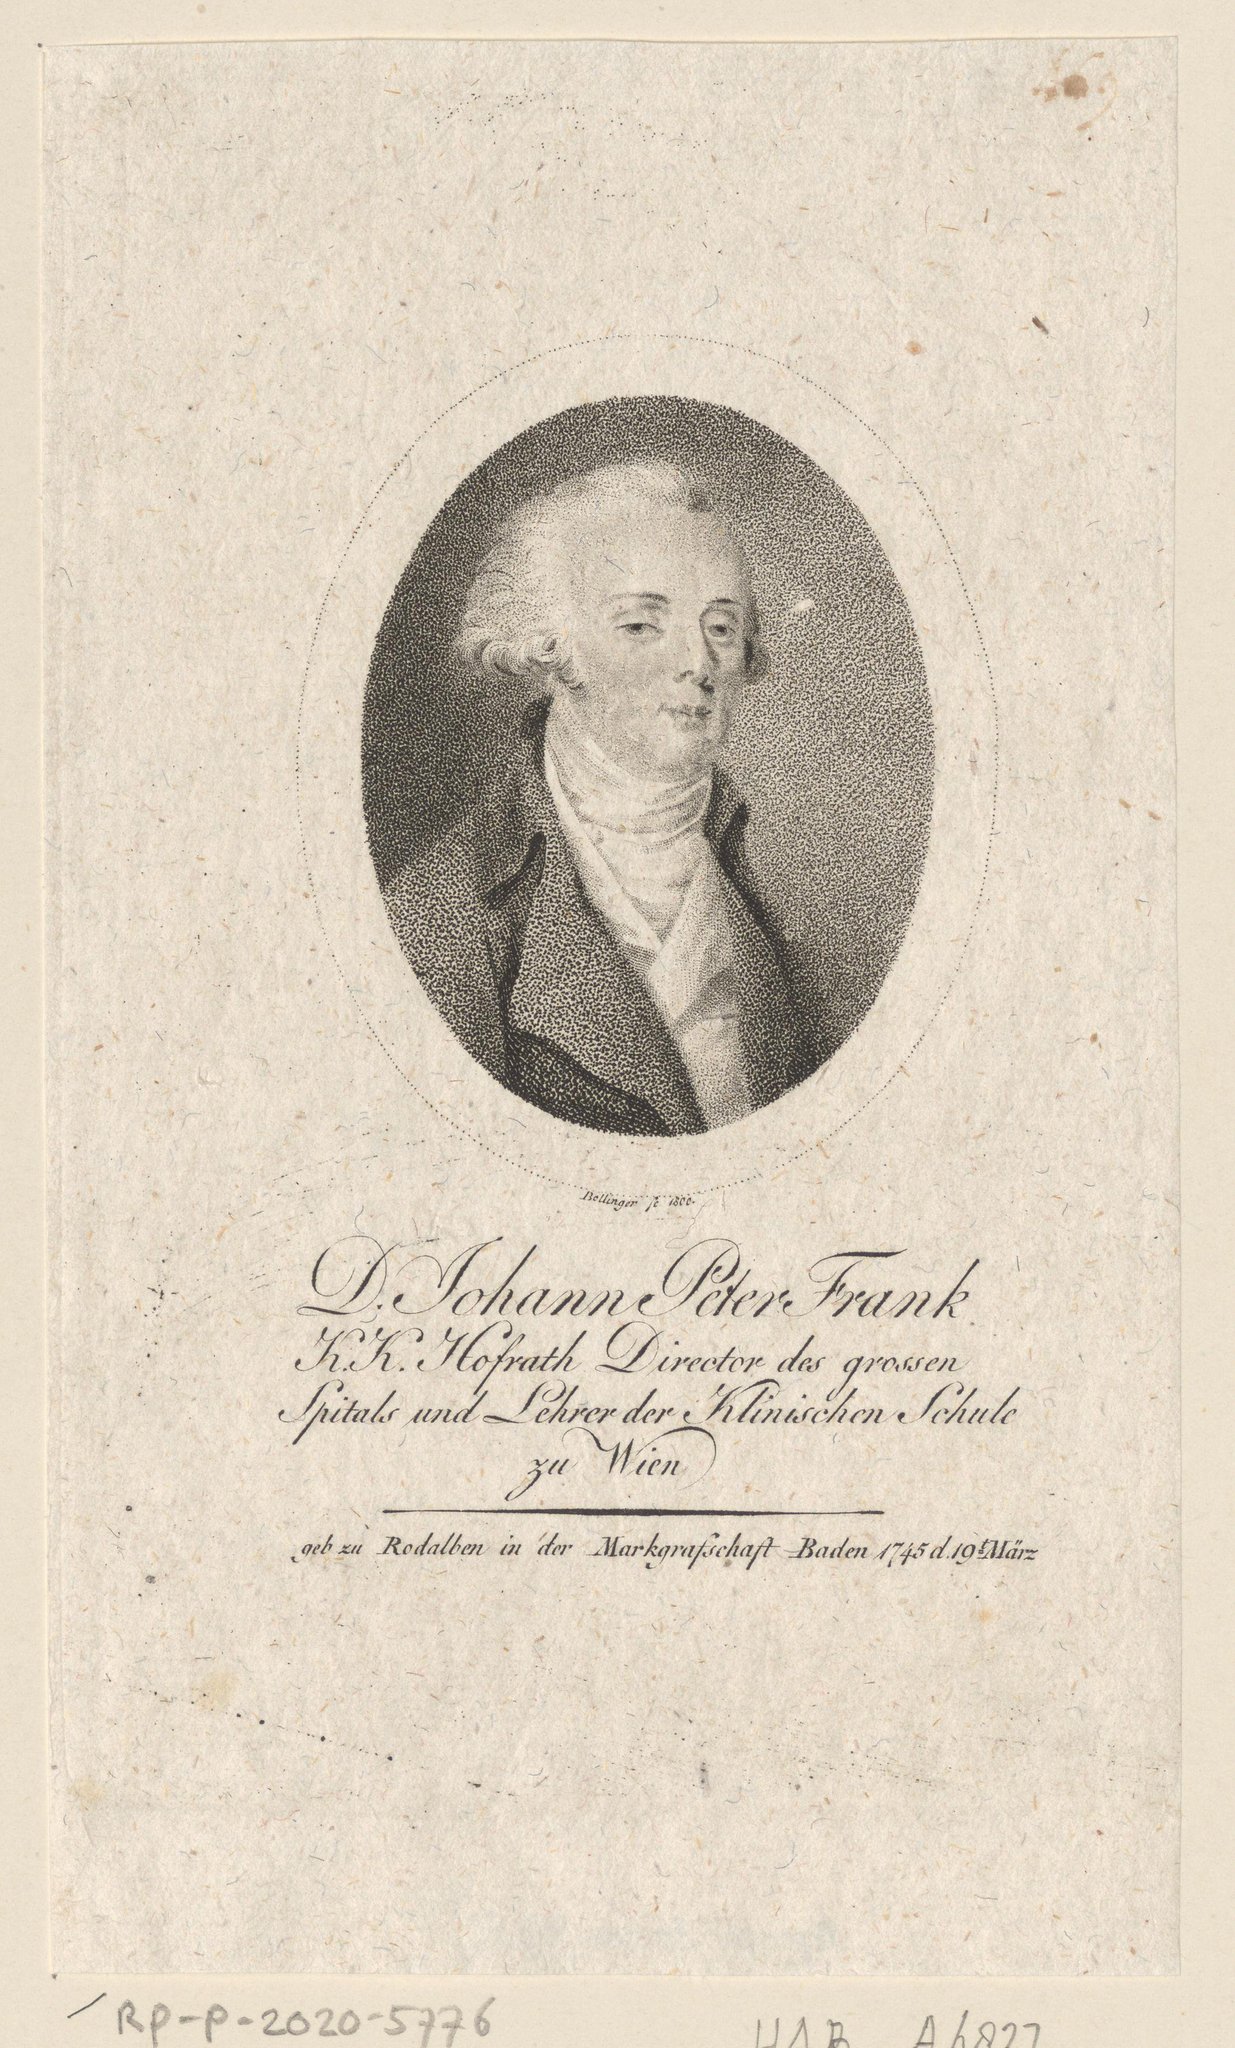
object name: print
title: Portret van Johann Peter Frank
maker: friedrich wilhelm bollinger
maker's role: print maker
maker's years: 1777-1825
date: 1800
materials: paper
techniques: stippling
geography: germany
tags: vienna, historical persons, physician, doctor (+ portrait of scholar, scientist)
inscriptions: date